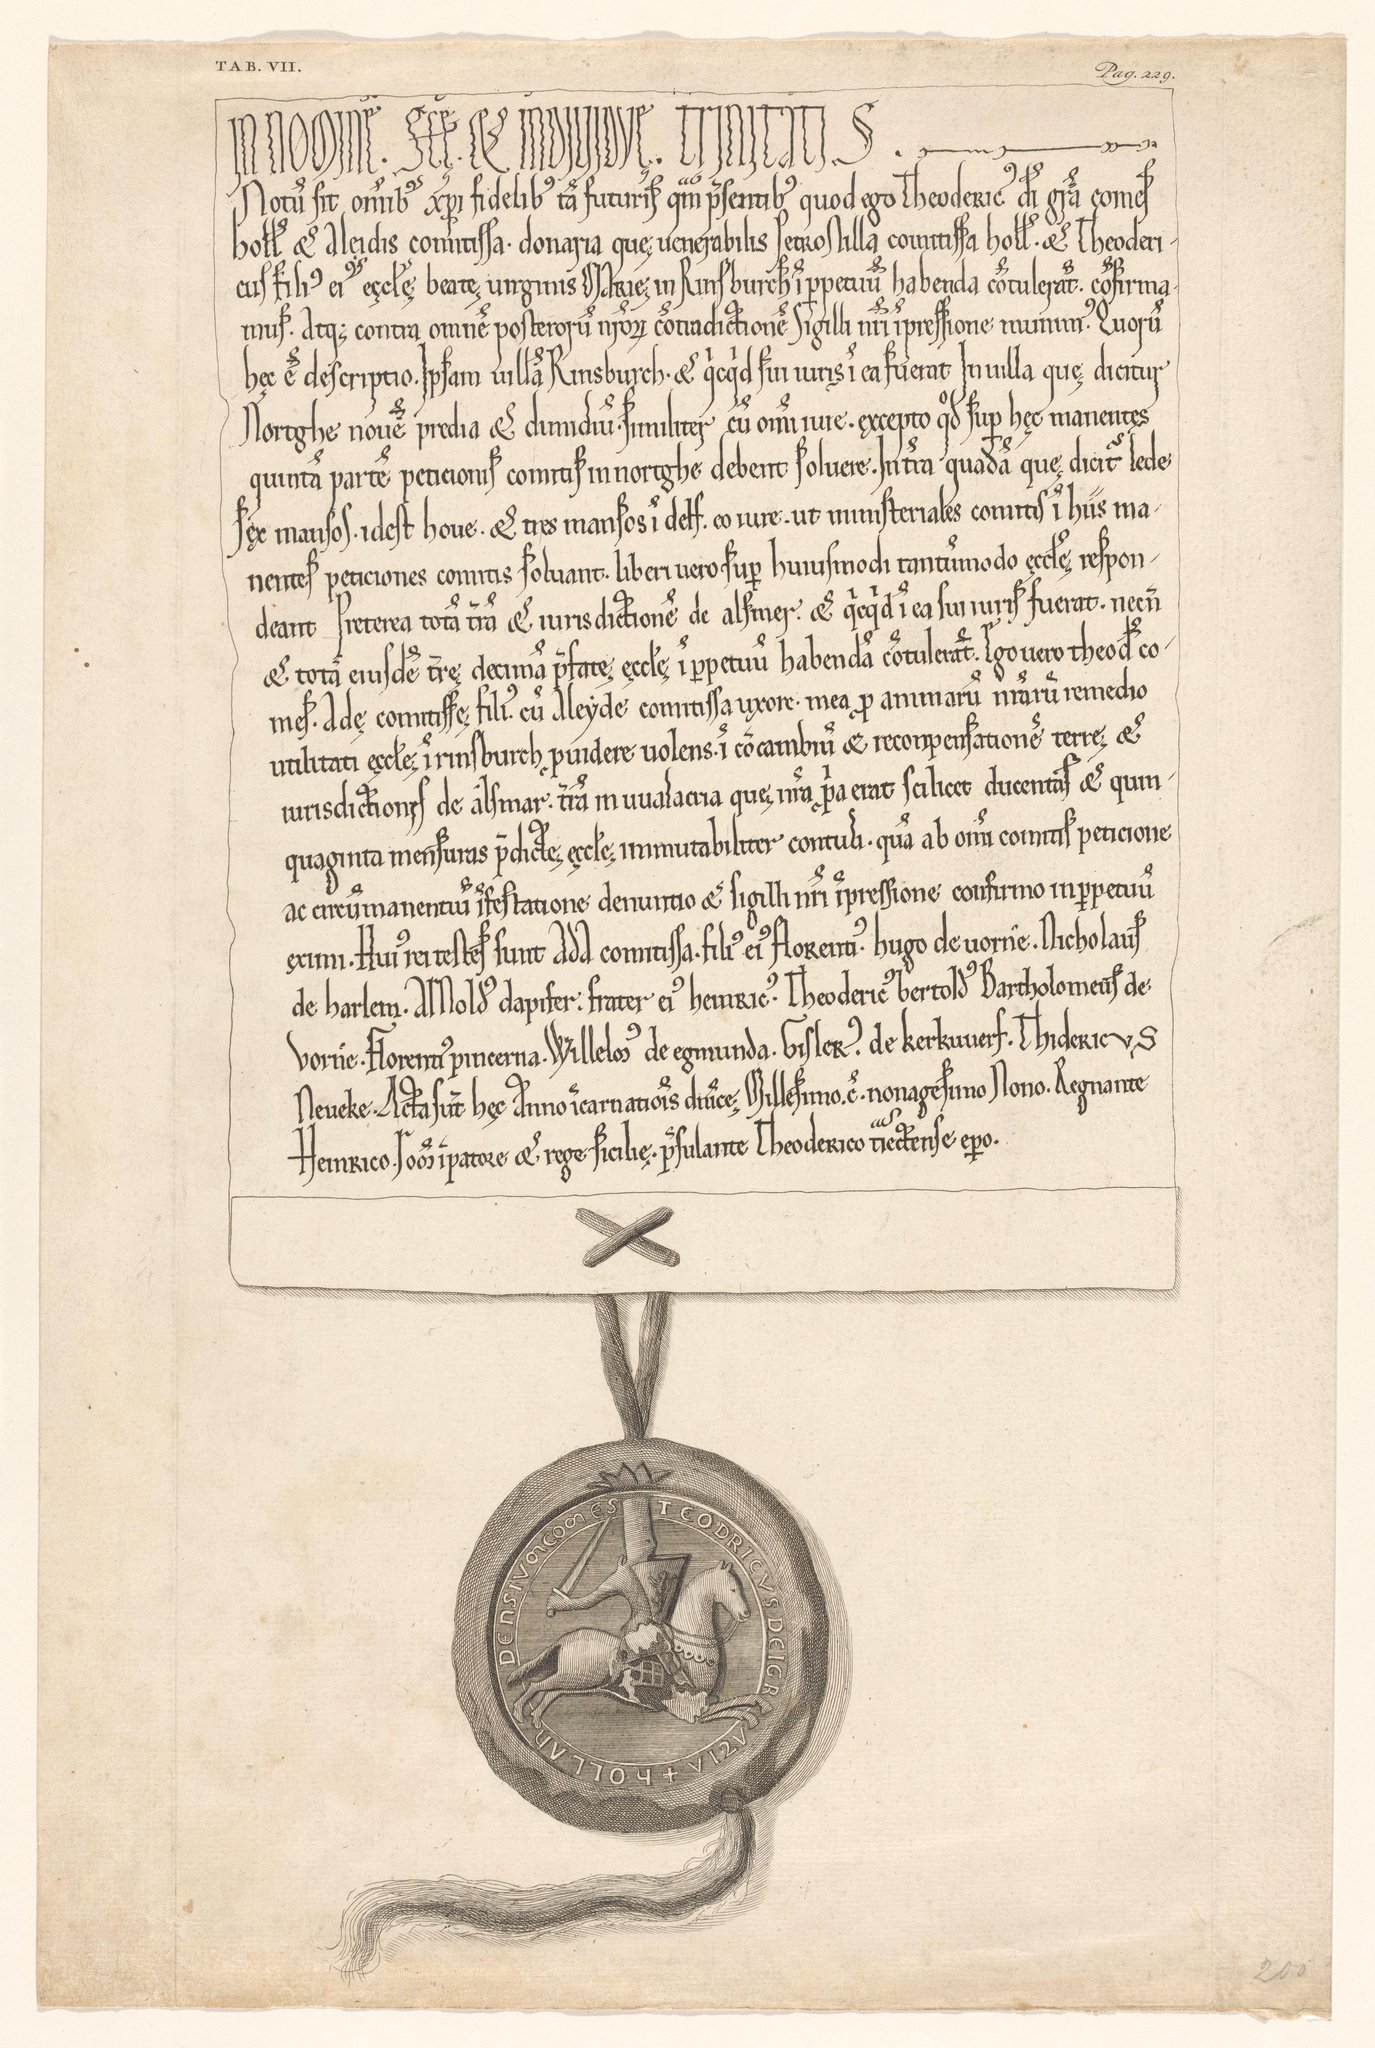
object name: book illustration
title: Papier met giften van Dirk VII van Holland en Aleid van Kleef aan de Abdij te Rijnsburg, 1199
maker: Anonymous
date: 1700-1799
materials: paper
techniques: engraving, etching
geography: northern netherlands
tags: dordrecht, seal, stamp, paper (writing material)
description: Papier met Latijnse tekst met daaronder een zegel met Dirk VII van Holland te paard. In de tekst bevestigen Dirk VII van Holland en Aleid van Kleef de giften die Petronilla van Saksen aan de Abdij van St. Marie heeft gedaan, waaronder de stad Rijnsburg. Linksboven: Tab. VII. Rechtsboven: Pag. 229.